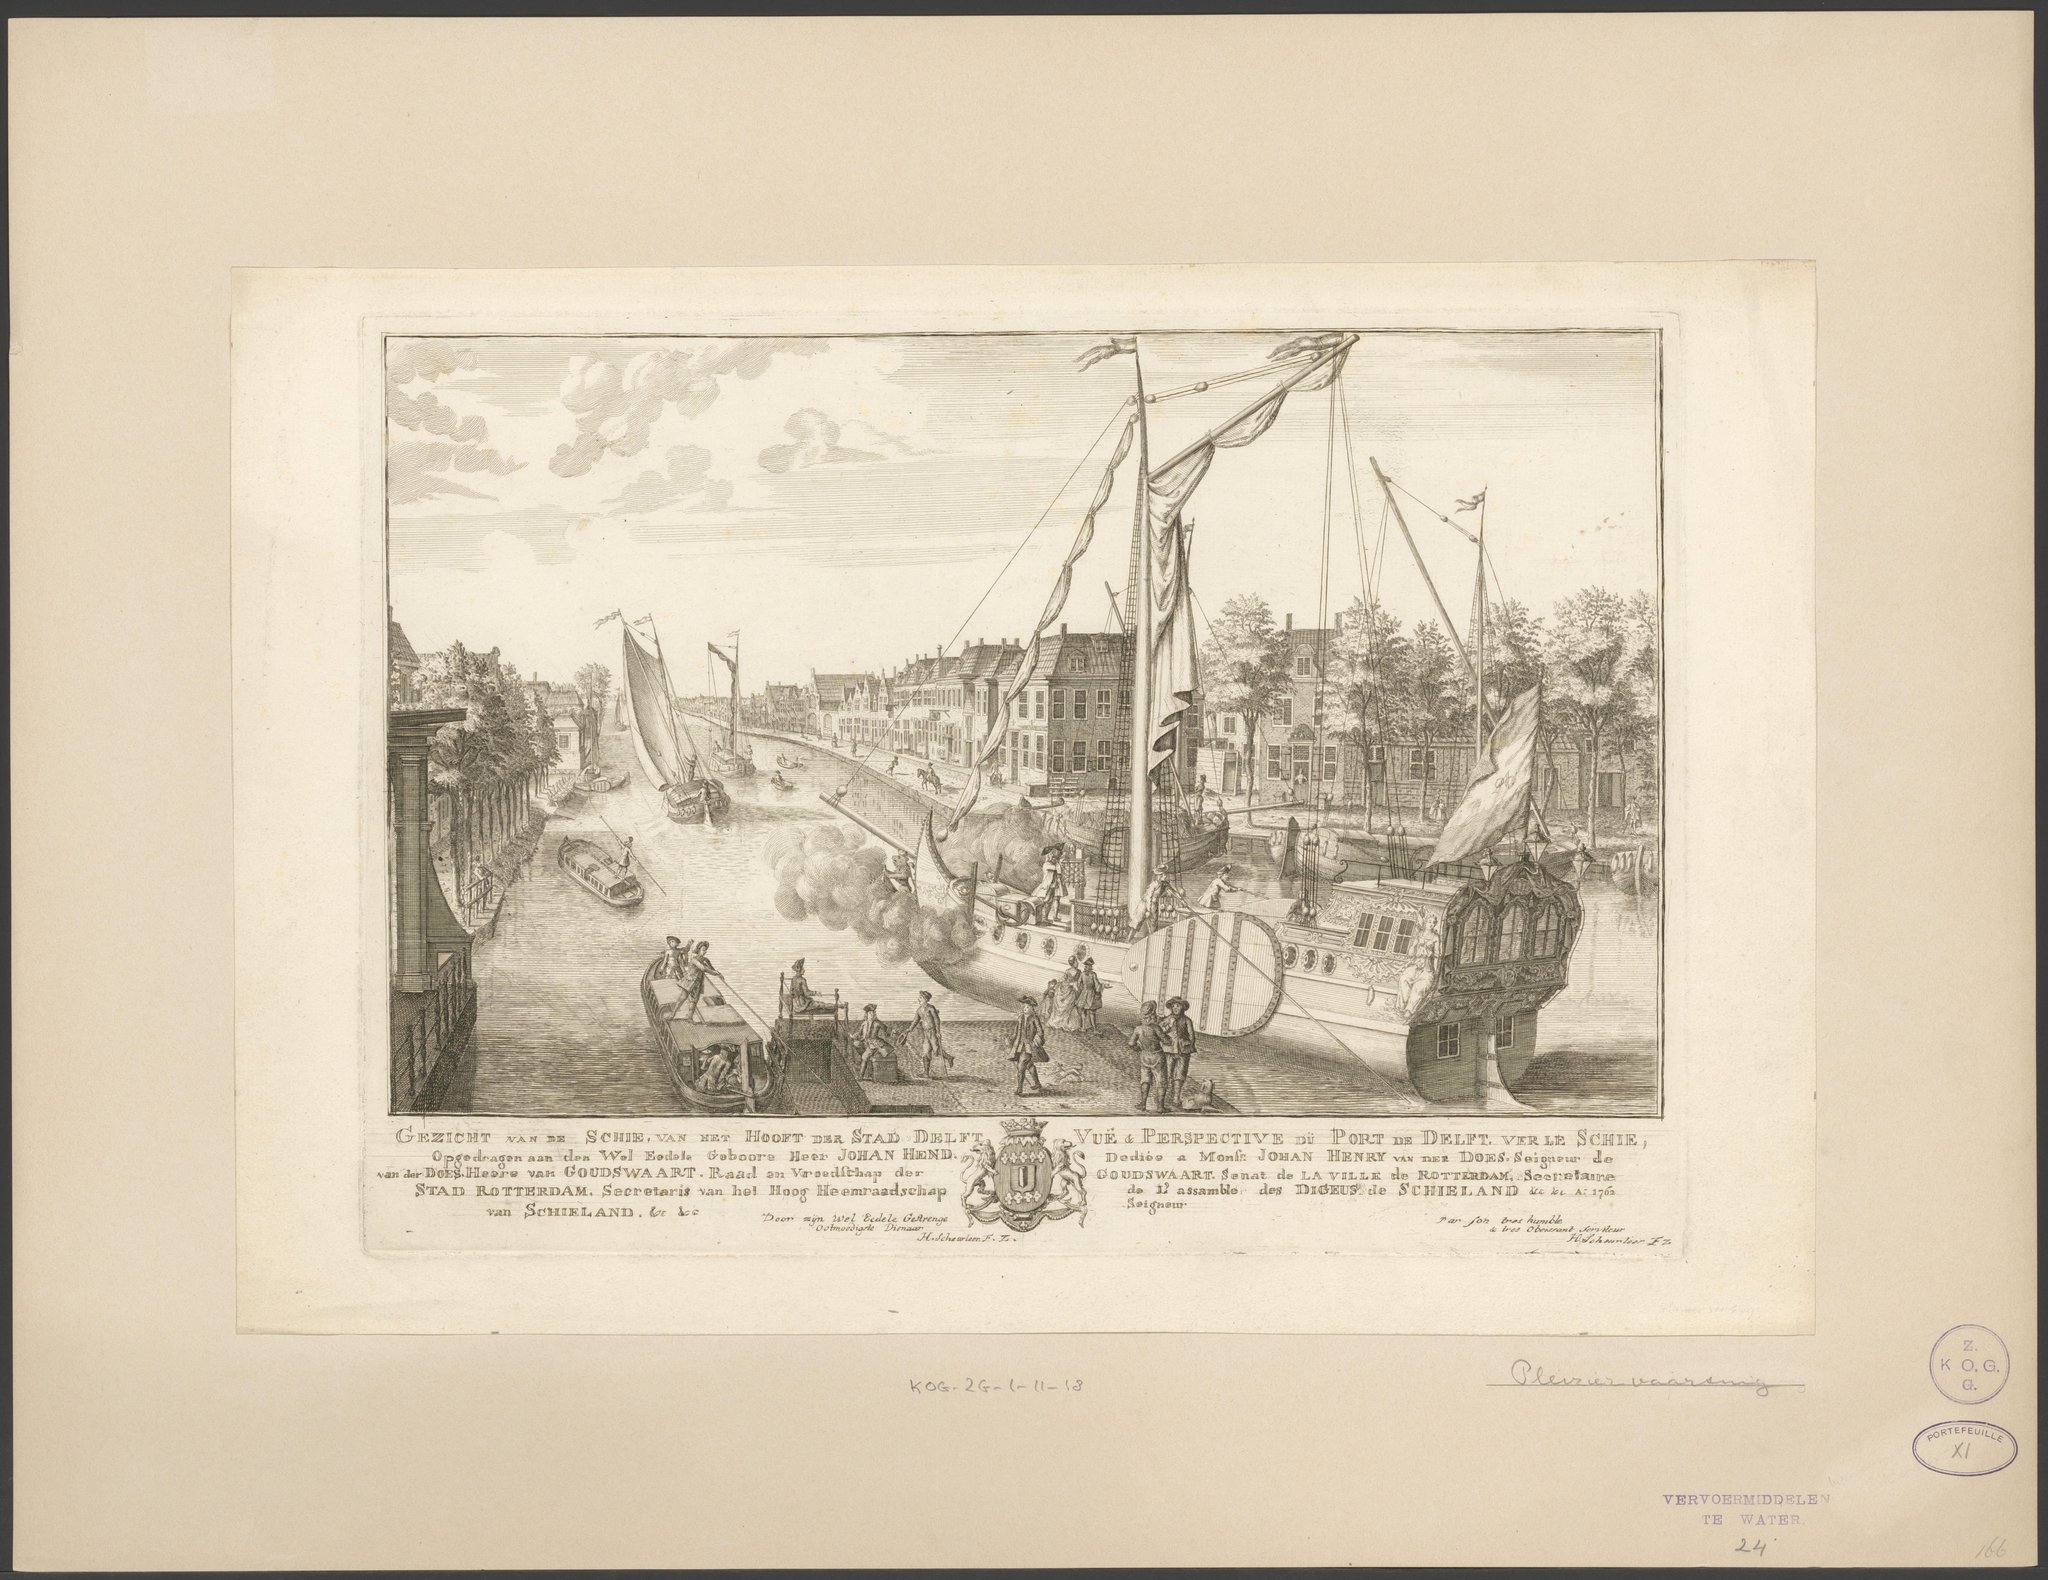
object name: print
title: Gezicht van de Schie, van het Hoofd der Stad Delft / Vuë & Perspective dü Port de Delft, ver le Schie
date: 1739-1768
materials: paper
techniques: etching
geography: the hague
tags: harbour, firearms: cannon, ships (in general) - cc - more than one ship, delft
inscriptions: collector's mark: Lugt 1641, stamp, stamp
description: Onderwerpsrubrieken binnen de Atlas Zeden en Gewoonten: Handel, nijverheid en verkeer, Vervoermiddelen te land en te water, Vervoermiddelen te water.